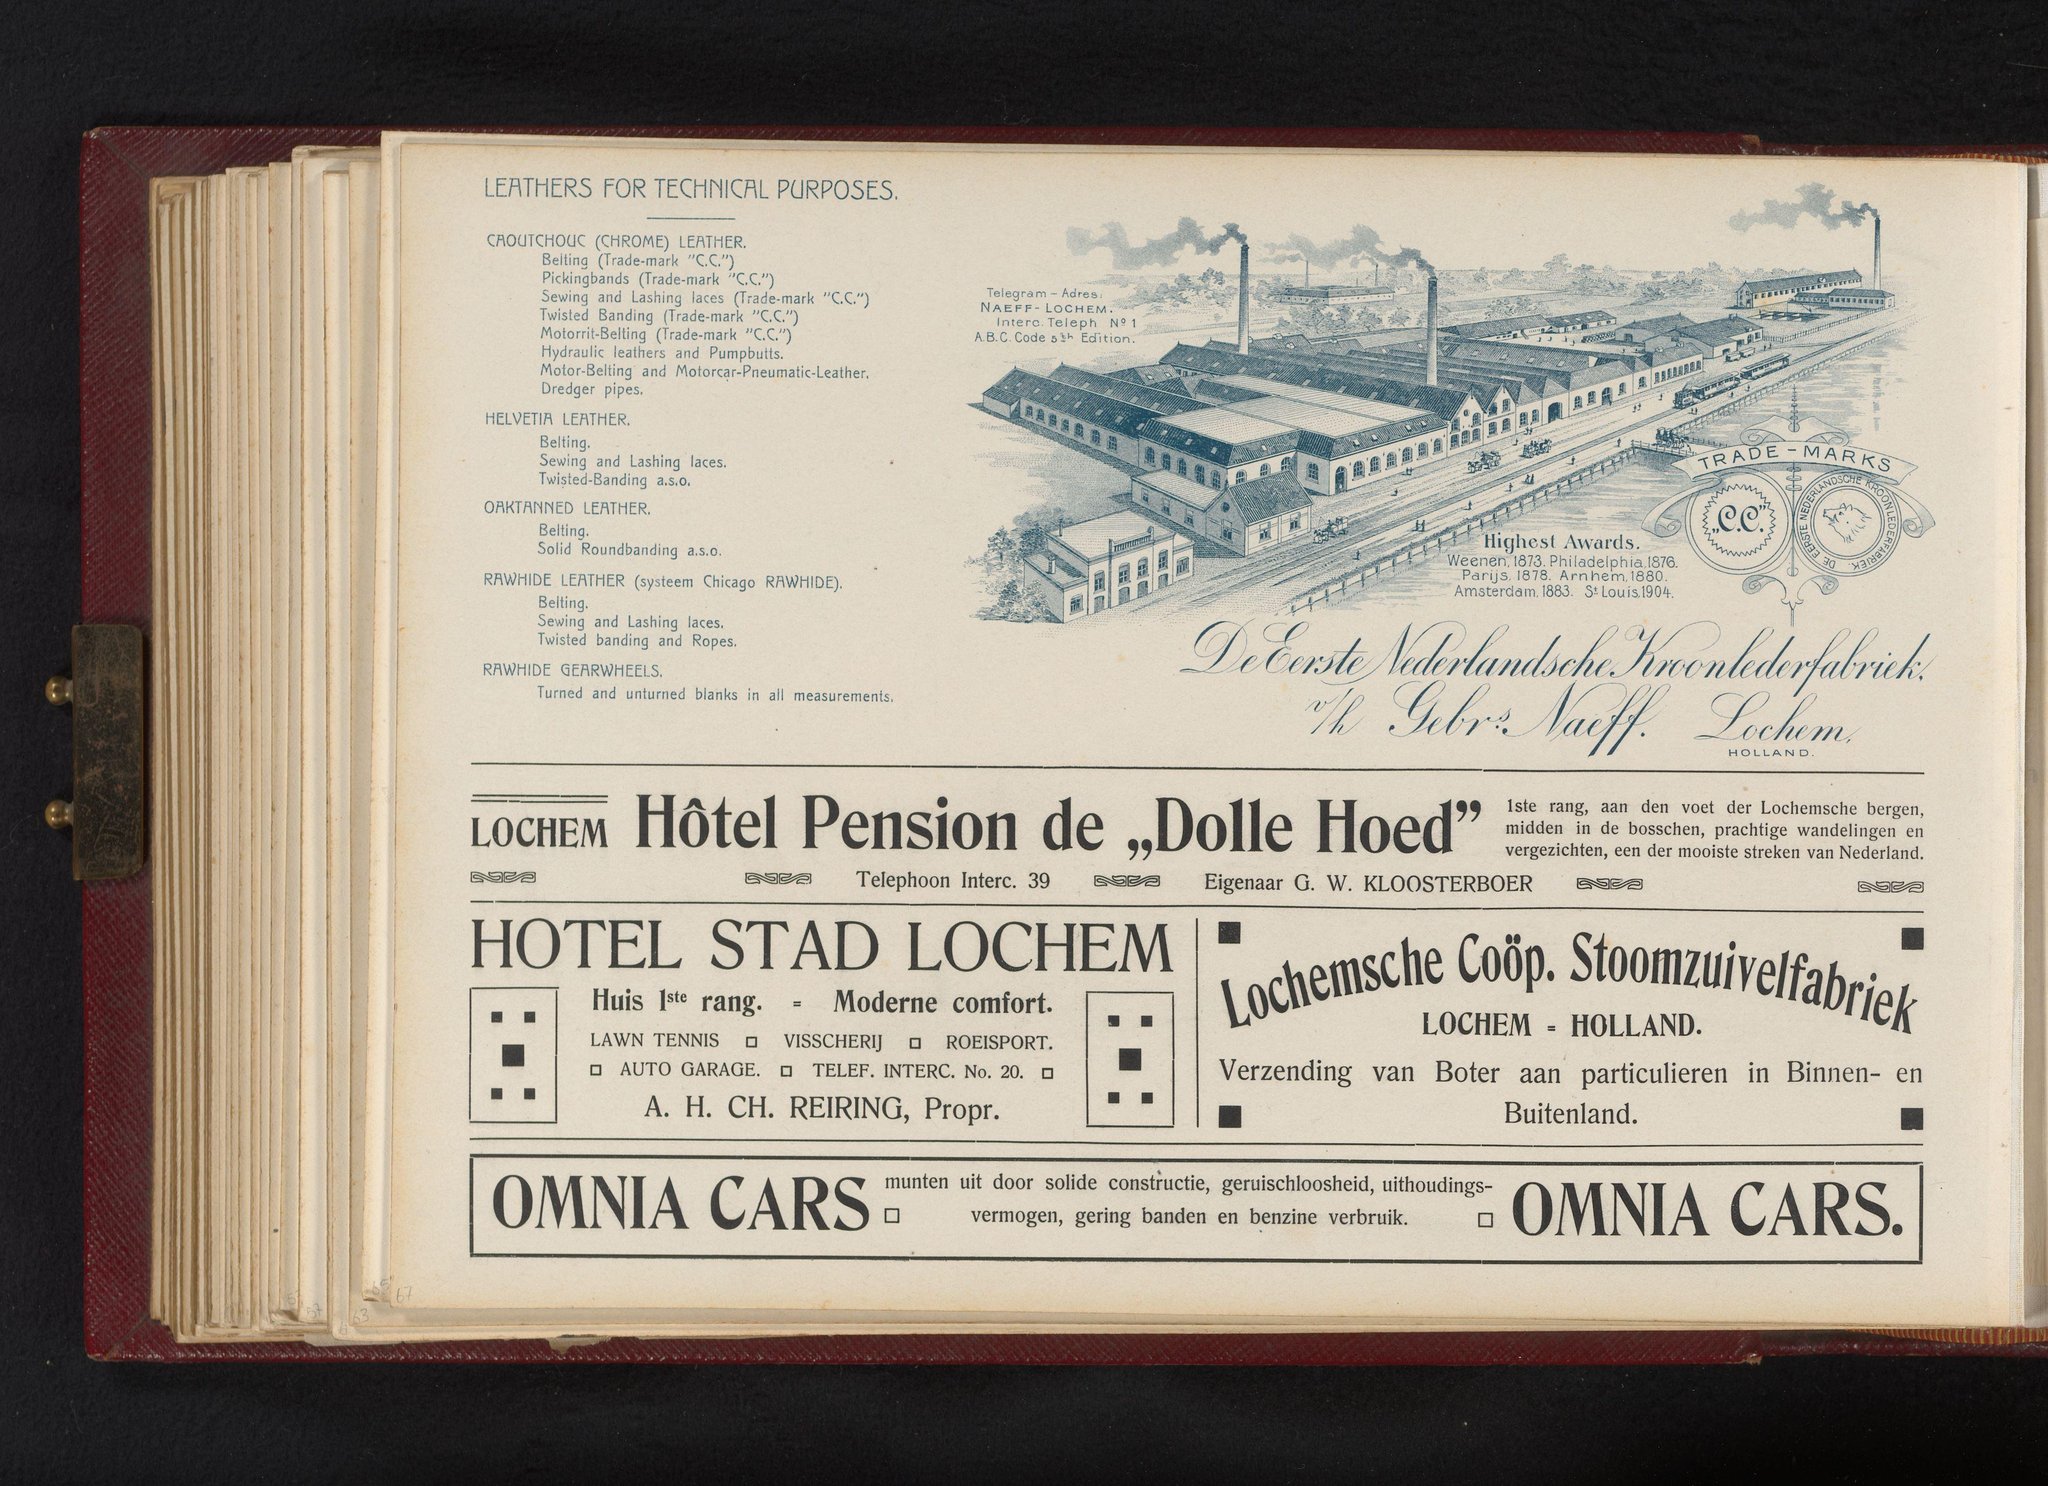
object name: album leaf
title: Advertenties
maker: Anonymous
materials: paper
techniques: printing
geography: netherlands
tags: advertising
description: Advertenties voor onder andere De Eerste Nederlandsche Kroonlederfabriek c/h Gebrs Naeff, Hôtel Pension de Dolle Hoed, Hotel Stad Lochem, Lochemsche Coöp Stoomzuivelfabriek en Omnia Cars. Deze pagina maakt deel uit van een album.